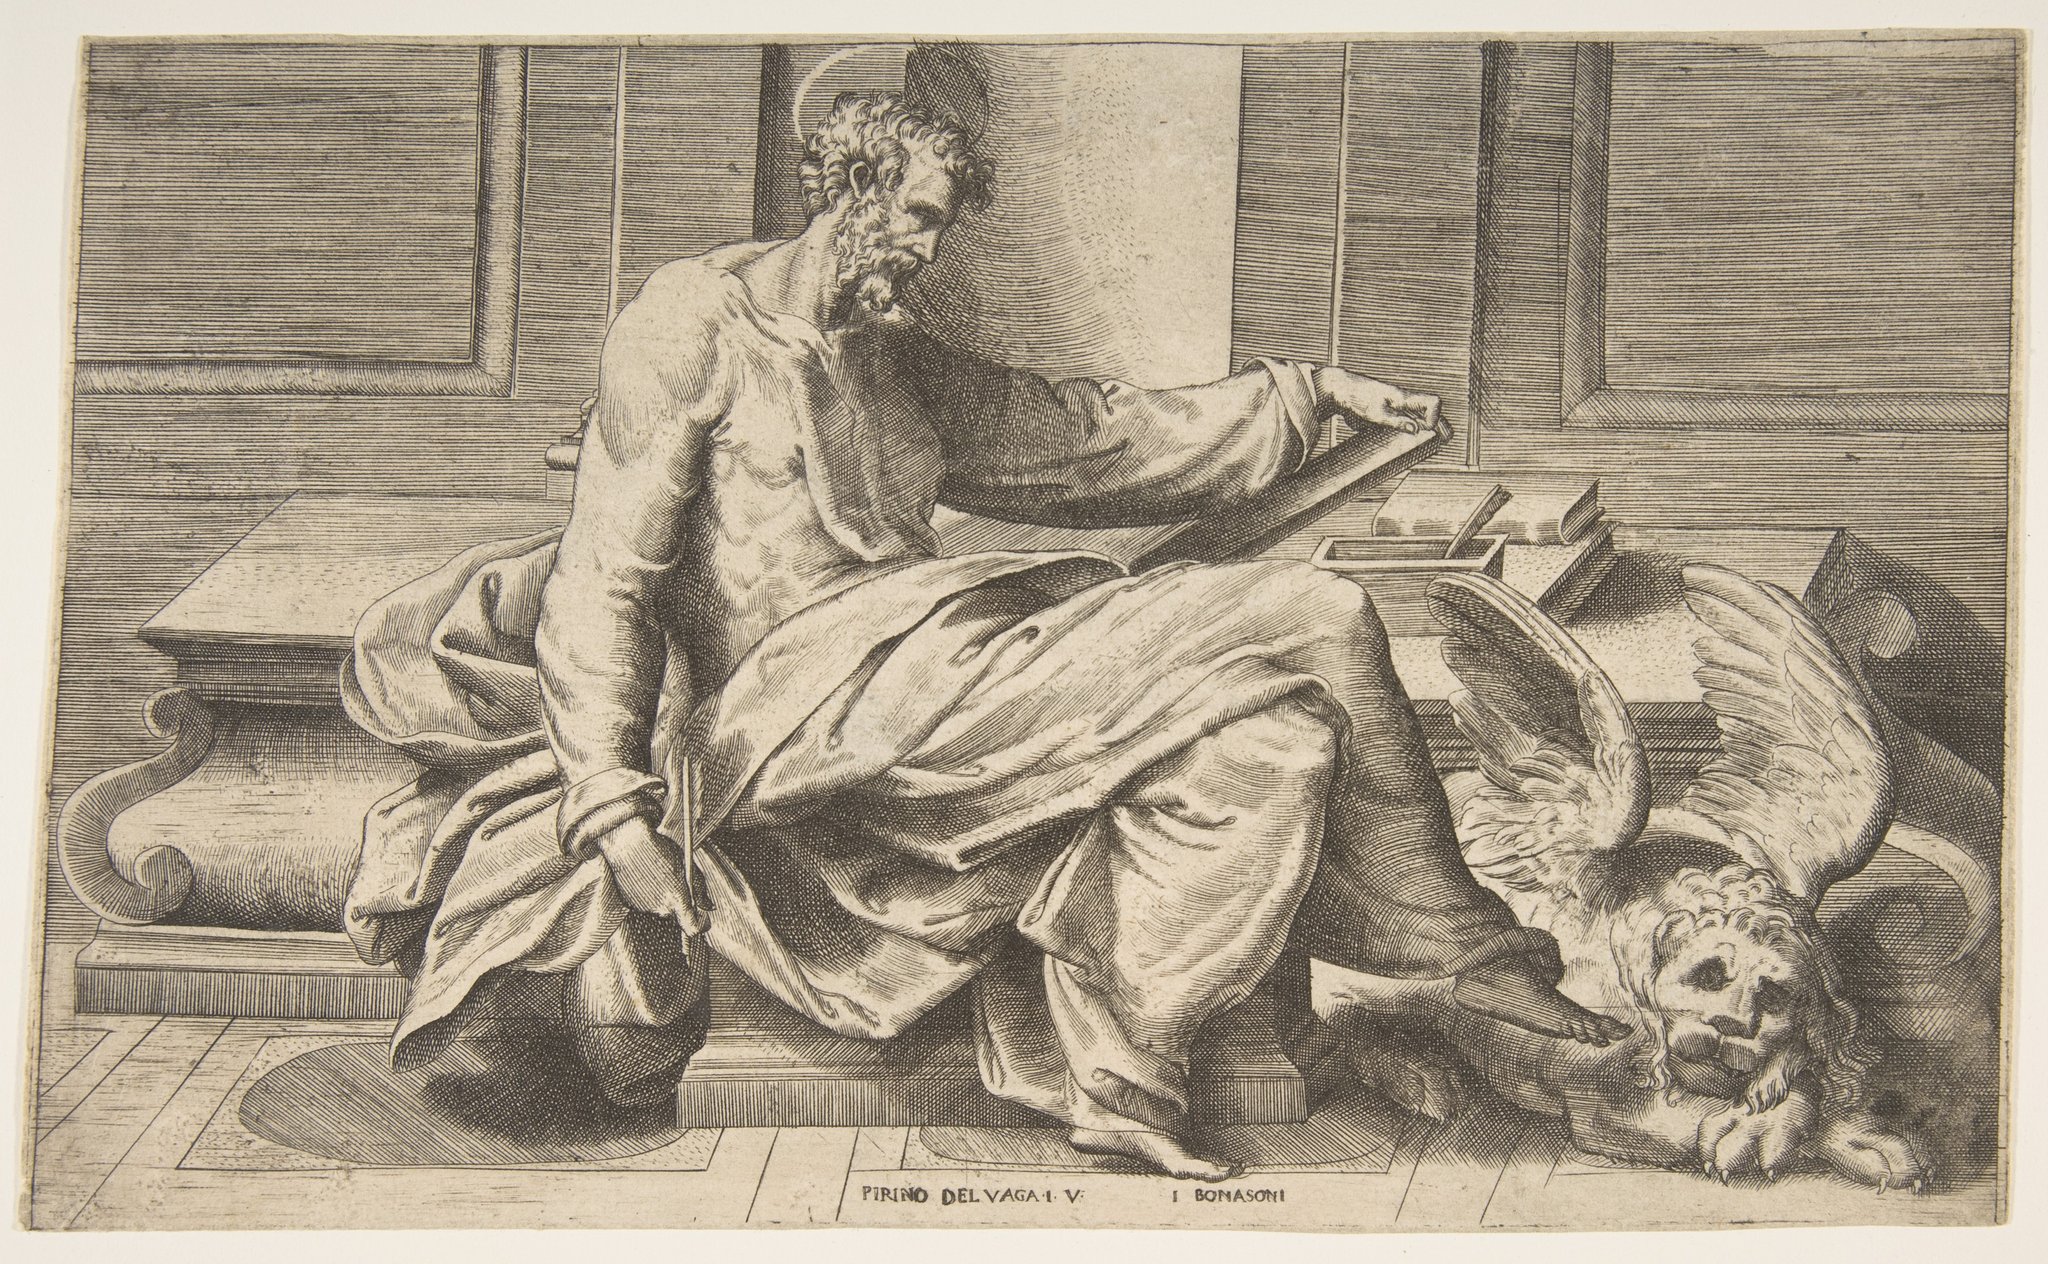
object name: print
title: Saint Mark writing his gospel, winged lion at the right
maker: giulio bonasone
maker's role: artist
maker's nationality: italian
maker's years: 1510-1576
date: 1531-1576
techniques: engraving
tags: saint mark,writing